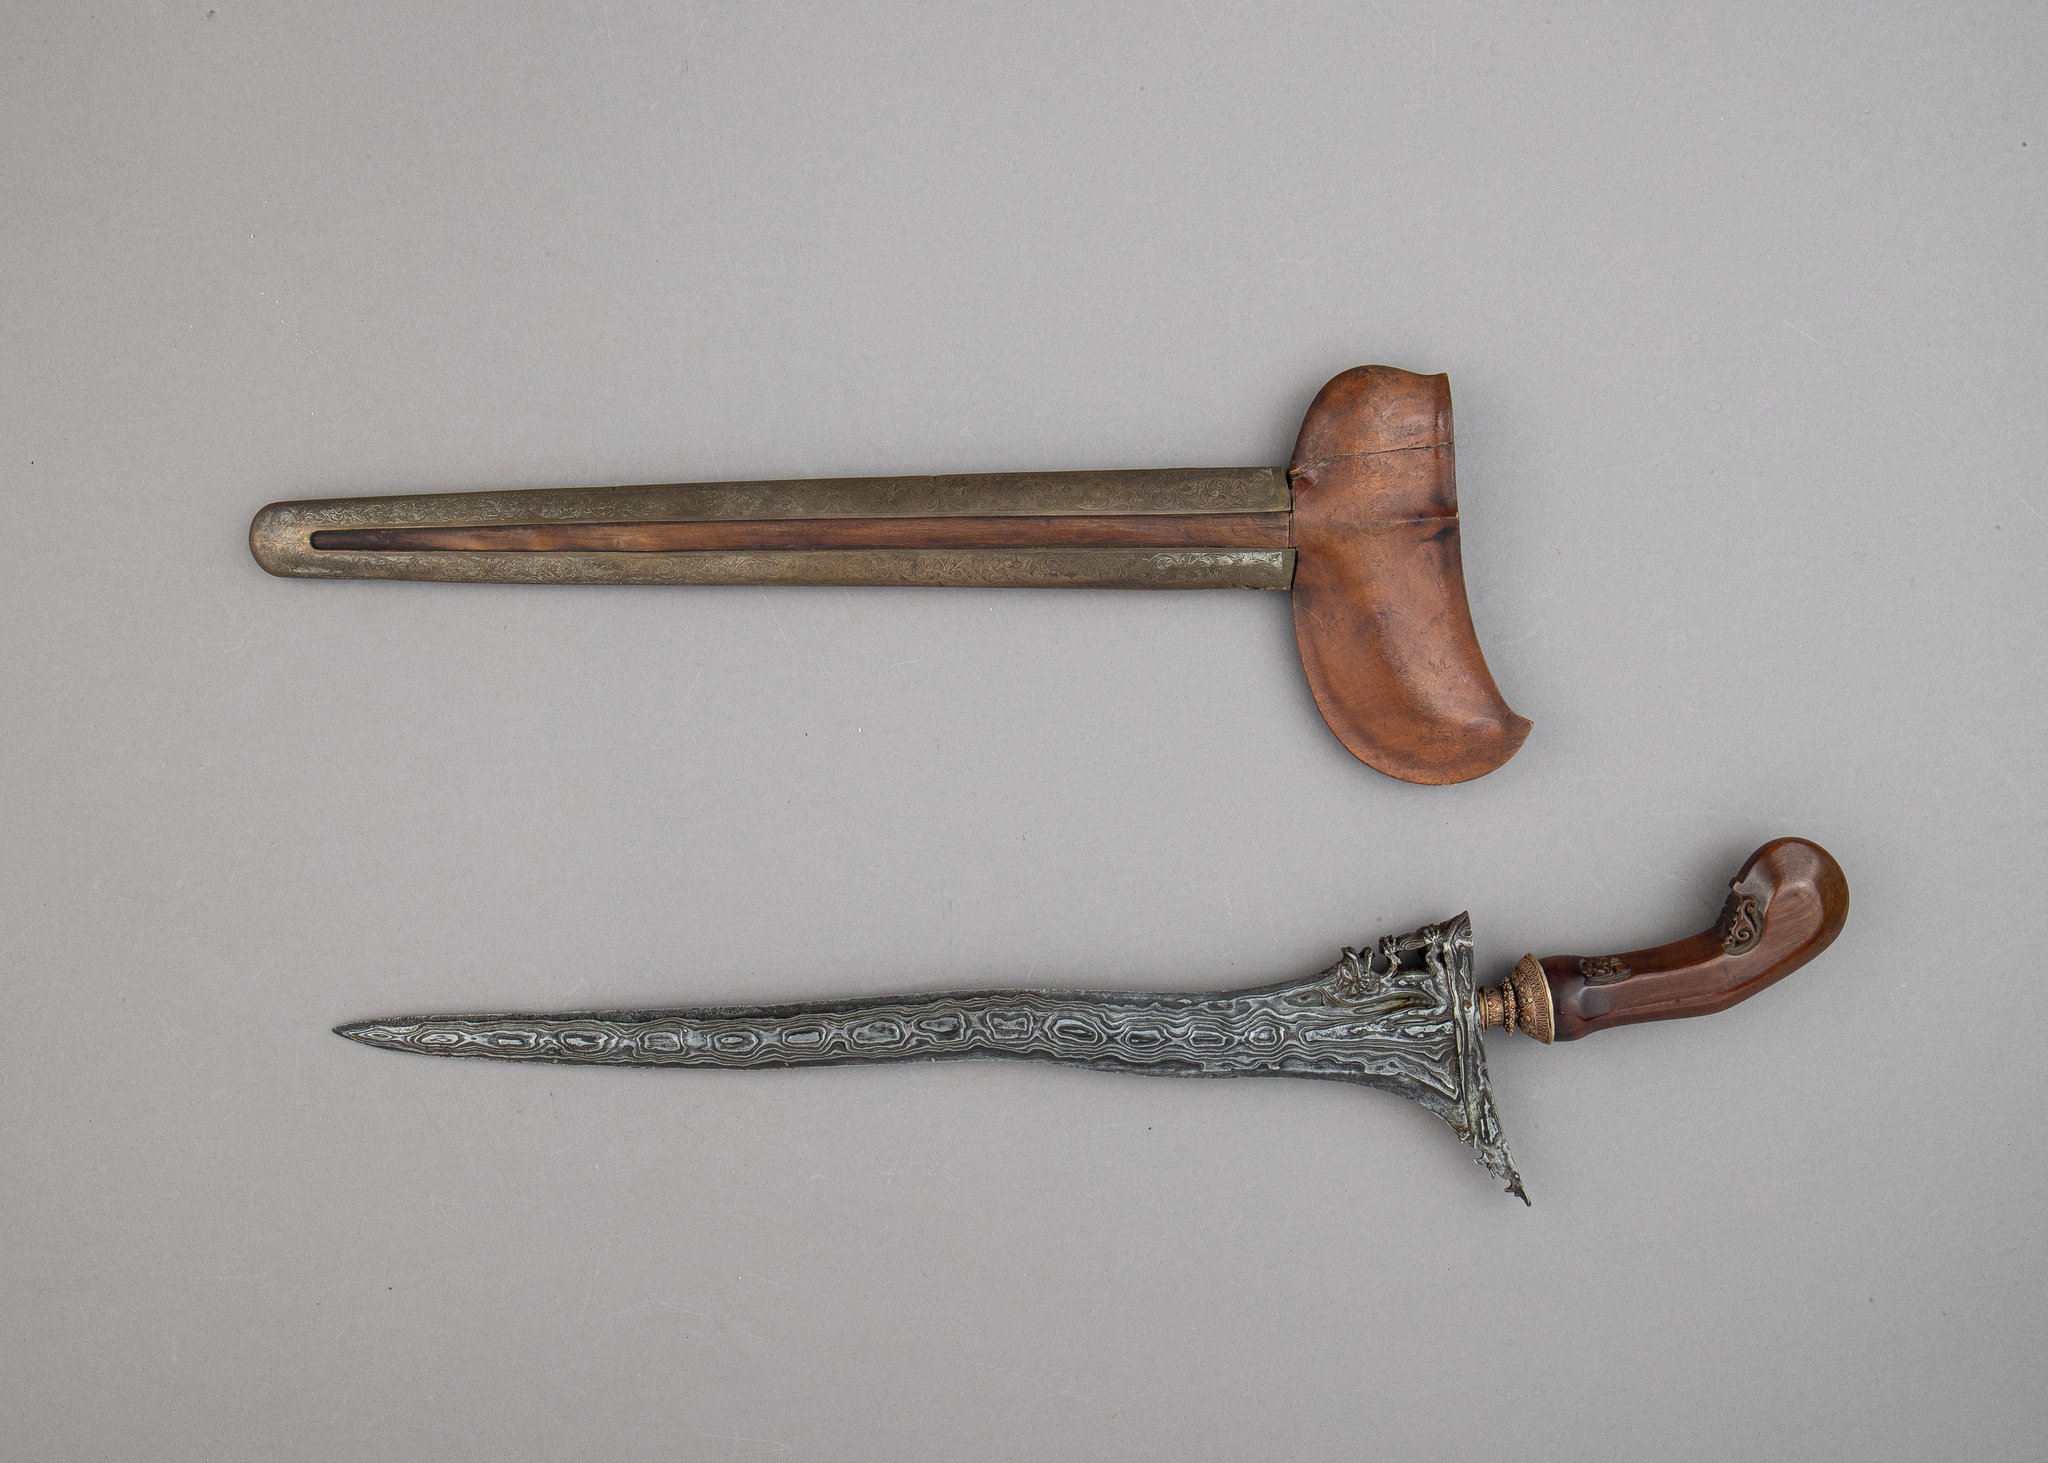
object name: kris with sheath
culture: javanese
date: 1501-1900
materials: copper, gold, steel, wood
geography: indonesia